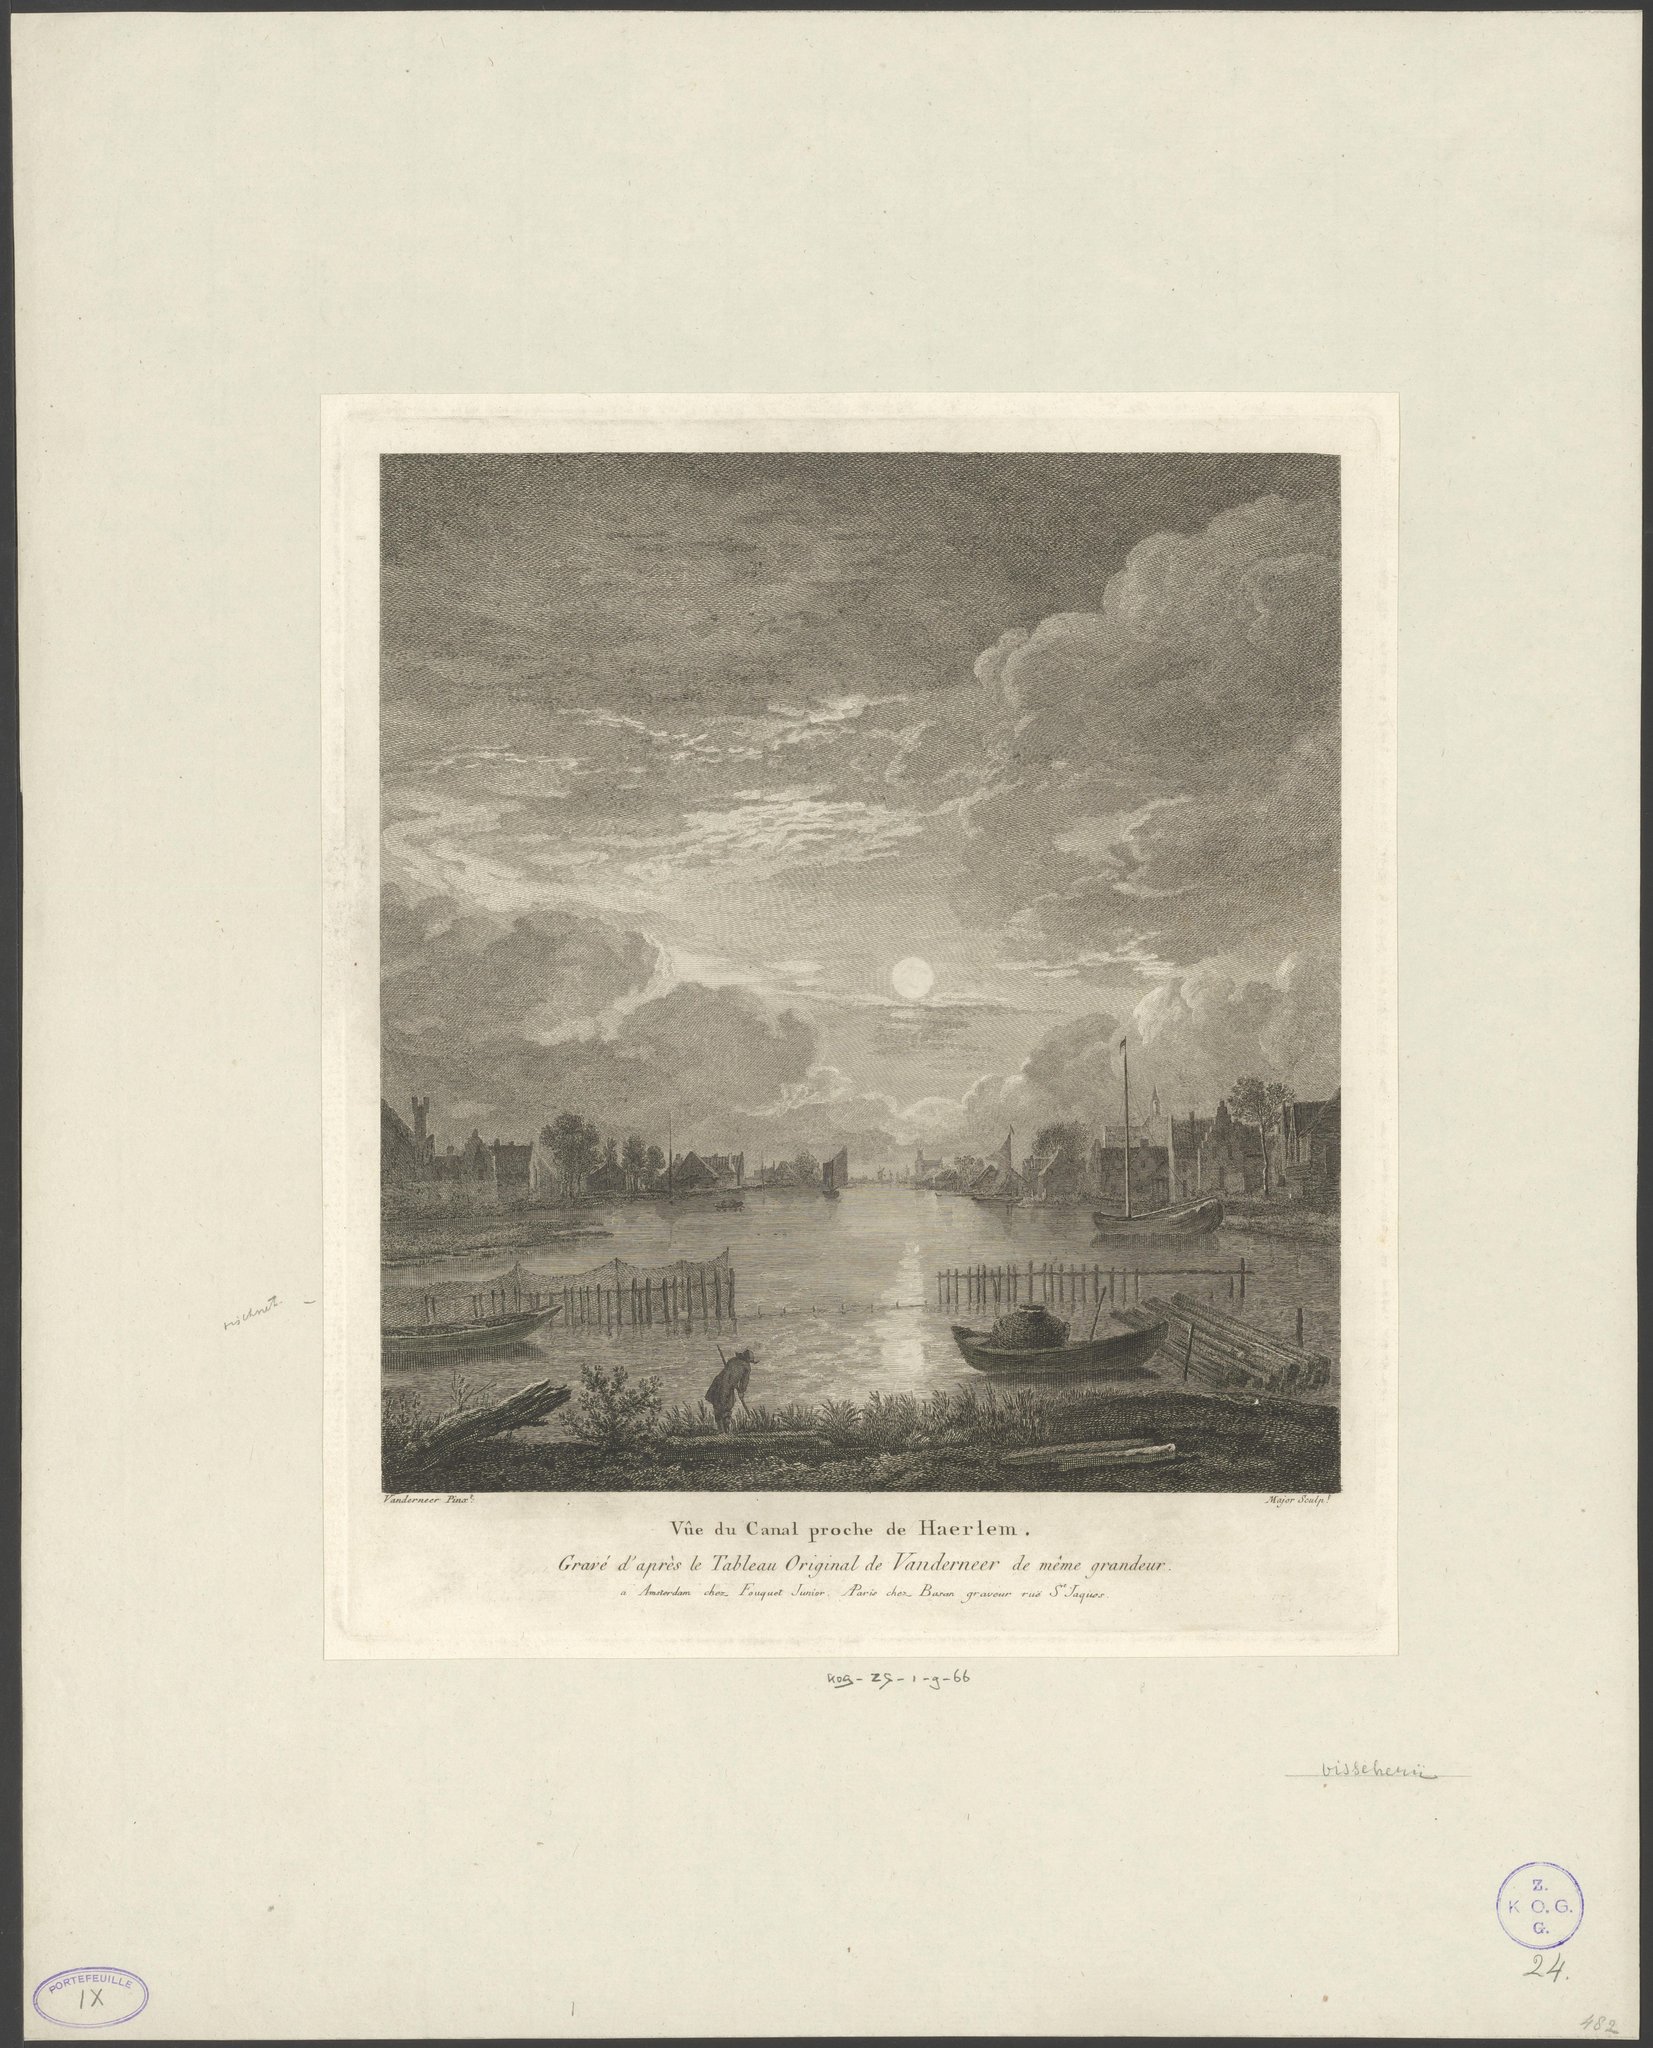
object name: print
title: Vûe du Canal proche de Haerlem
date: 1745-1750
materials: paper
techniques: etching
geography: paris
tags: sailing-ship, sailing-boat, canal, night ~ landscape (sometimes titled 'nox'), haarlem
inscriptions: collector's mark: Lugt 1641, stamp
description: Aan het water staan huizen en op het water liggen schepen en boten. Op de voorgrond staat een man met een stok in het water. Onderwerpsrubrieken binnen de Atlas Zeden en Gewoonten: Handel, nijverheid en verkeer, Zee- en Riviervisscherij.